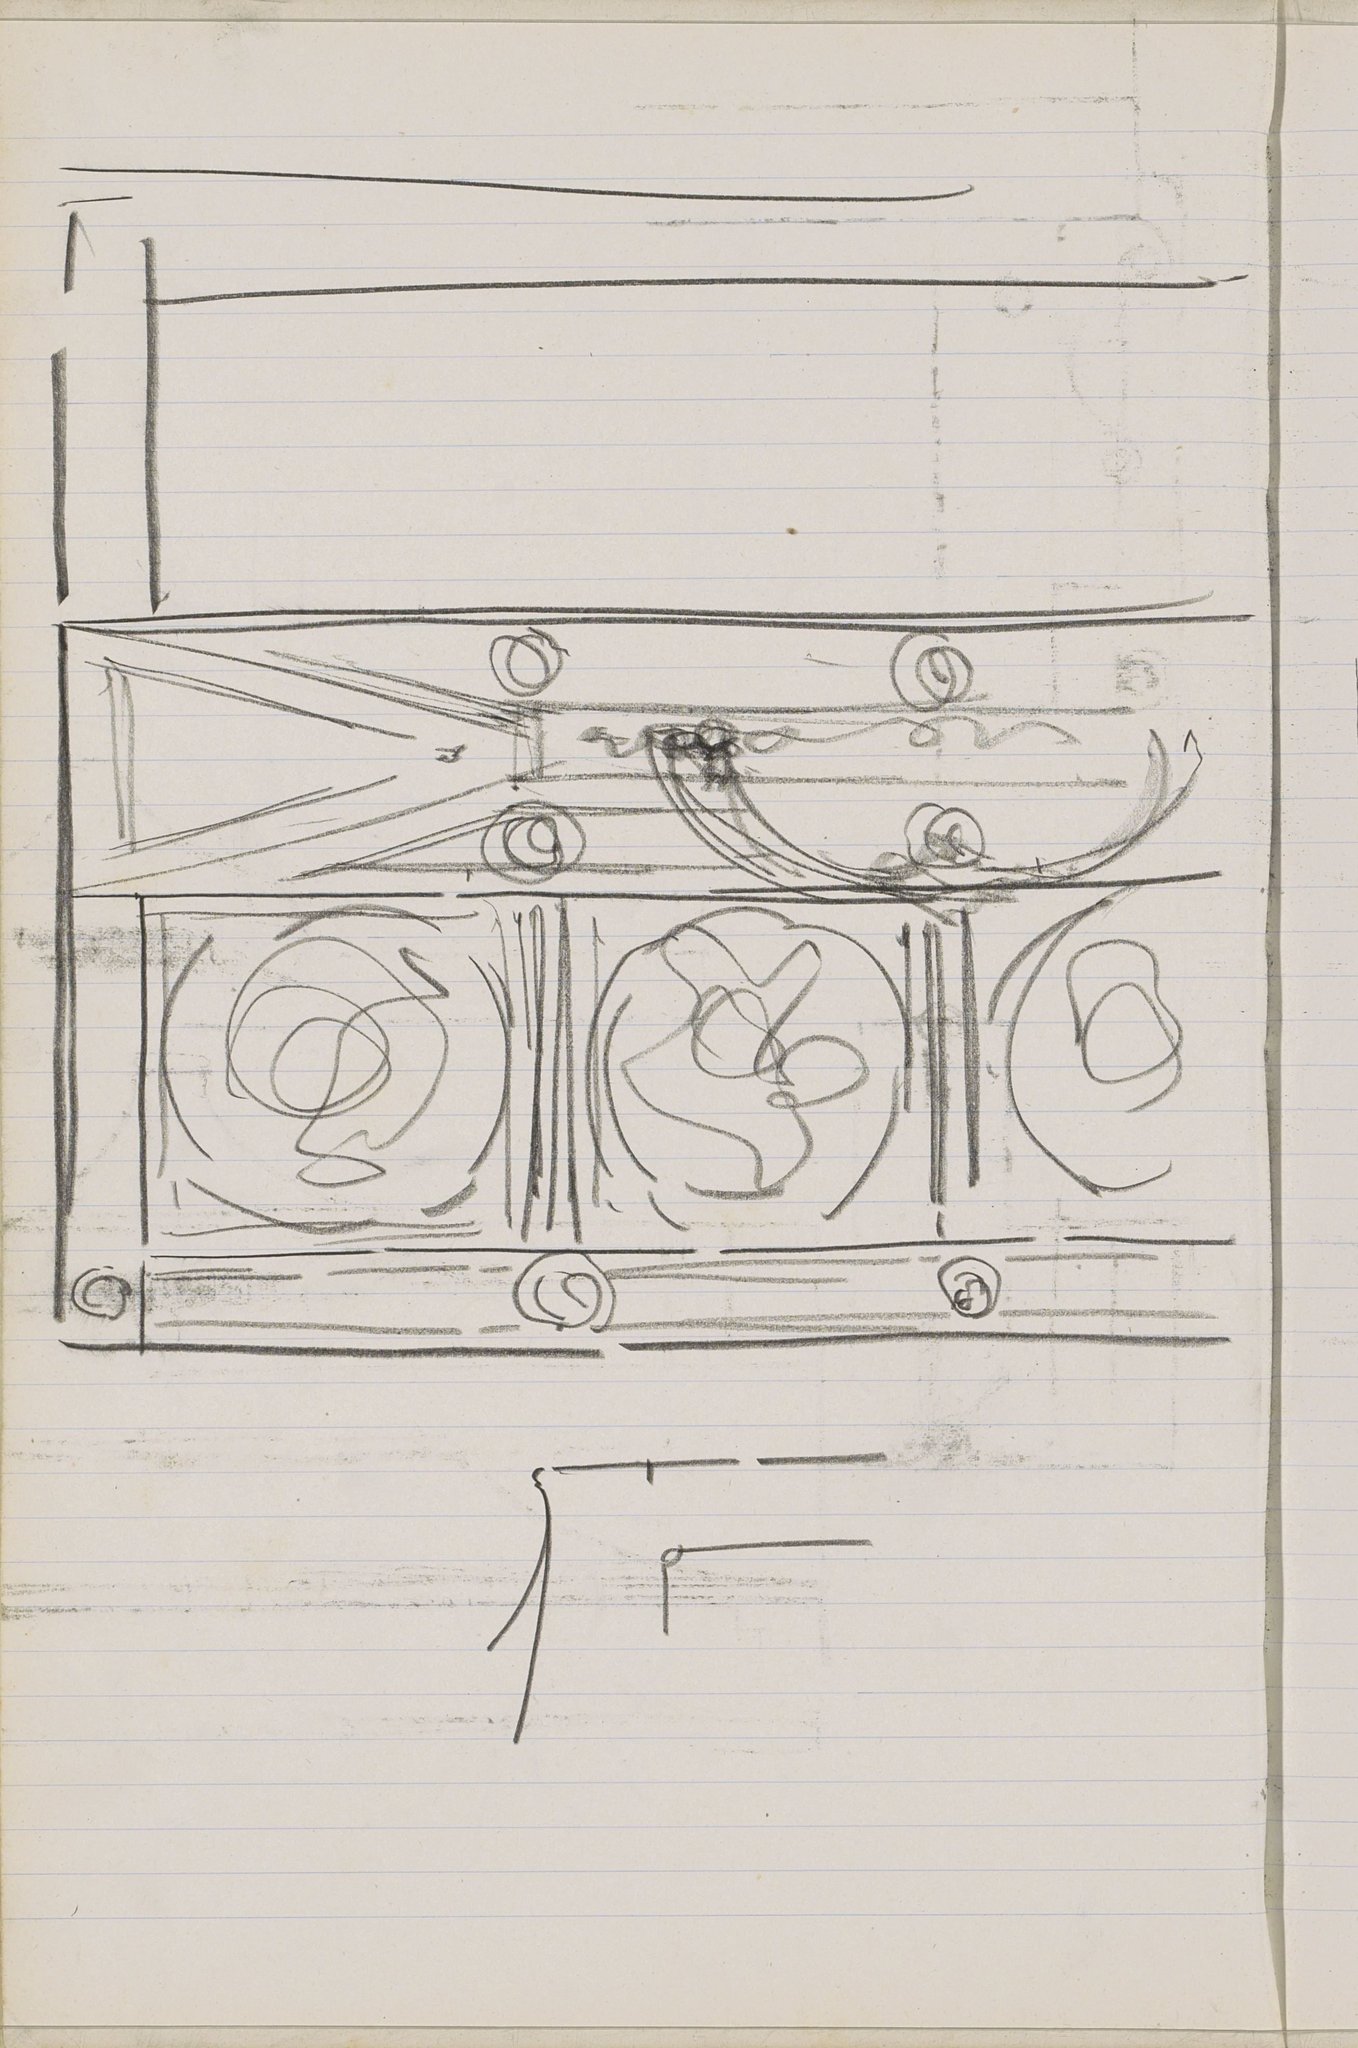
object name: sketchbook leaf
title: Gedecoreerd paneel of meubel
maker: gerrit willem dijsselhof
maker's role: designer, draughtsman, print maker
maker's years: 1866-1924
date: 1901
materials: chalk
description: Blad 61 verso uit een schetsboek met 79 bladen.